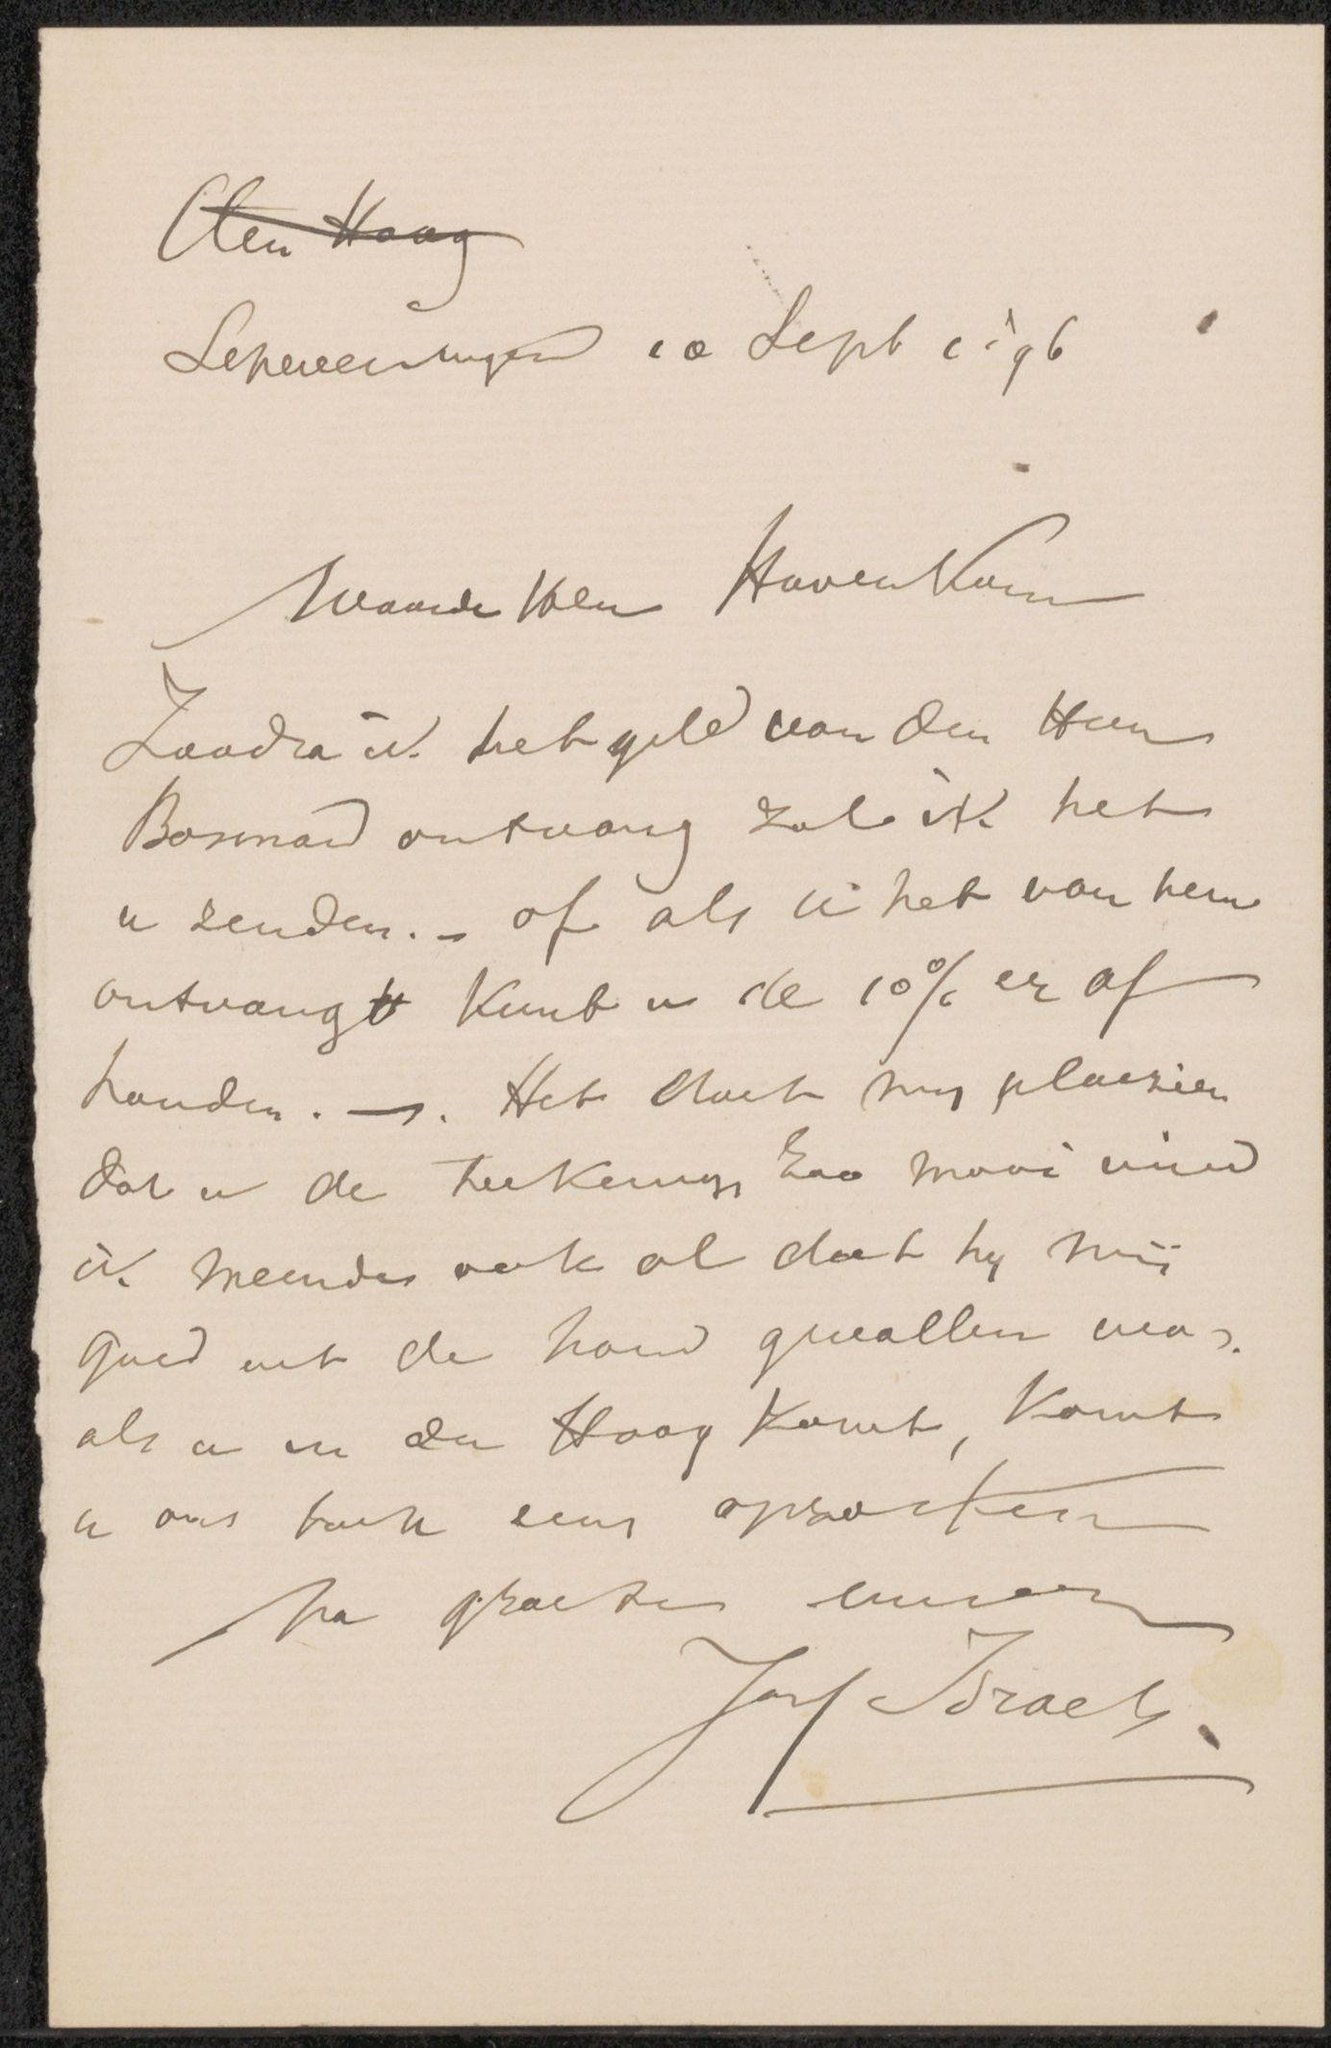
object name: letter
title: Brief aan Pieter Haverkorn van Rijsewijk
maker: jozef israëls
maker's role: draughtsman, painter, print maker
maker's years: 1824-1911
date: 1896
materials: ink, paper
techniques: pen, writing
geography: scheveningen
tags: pieter haverkorn van rijsewijk, drawing, money, the hague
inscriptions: collector's mark: ‘RPK’